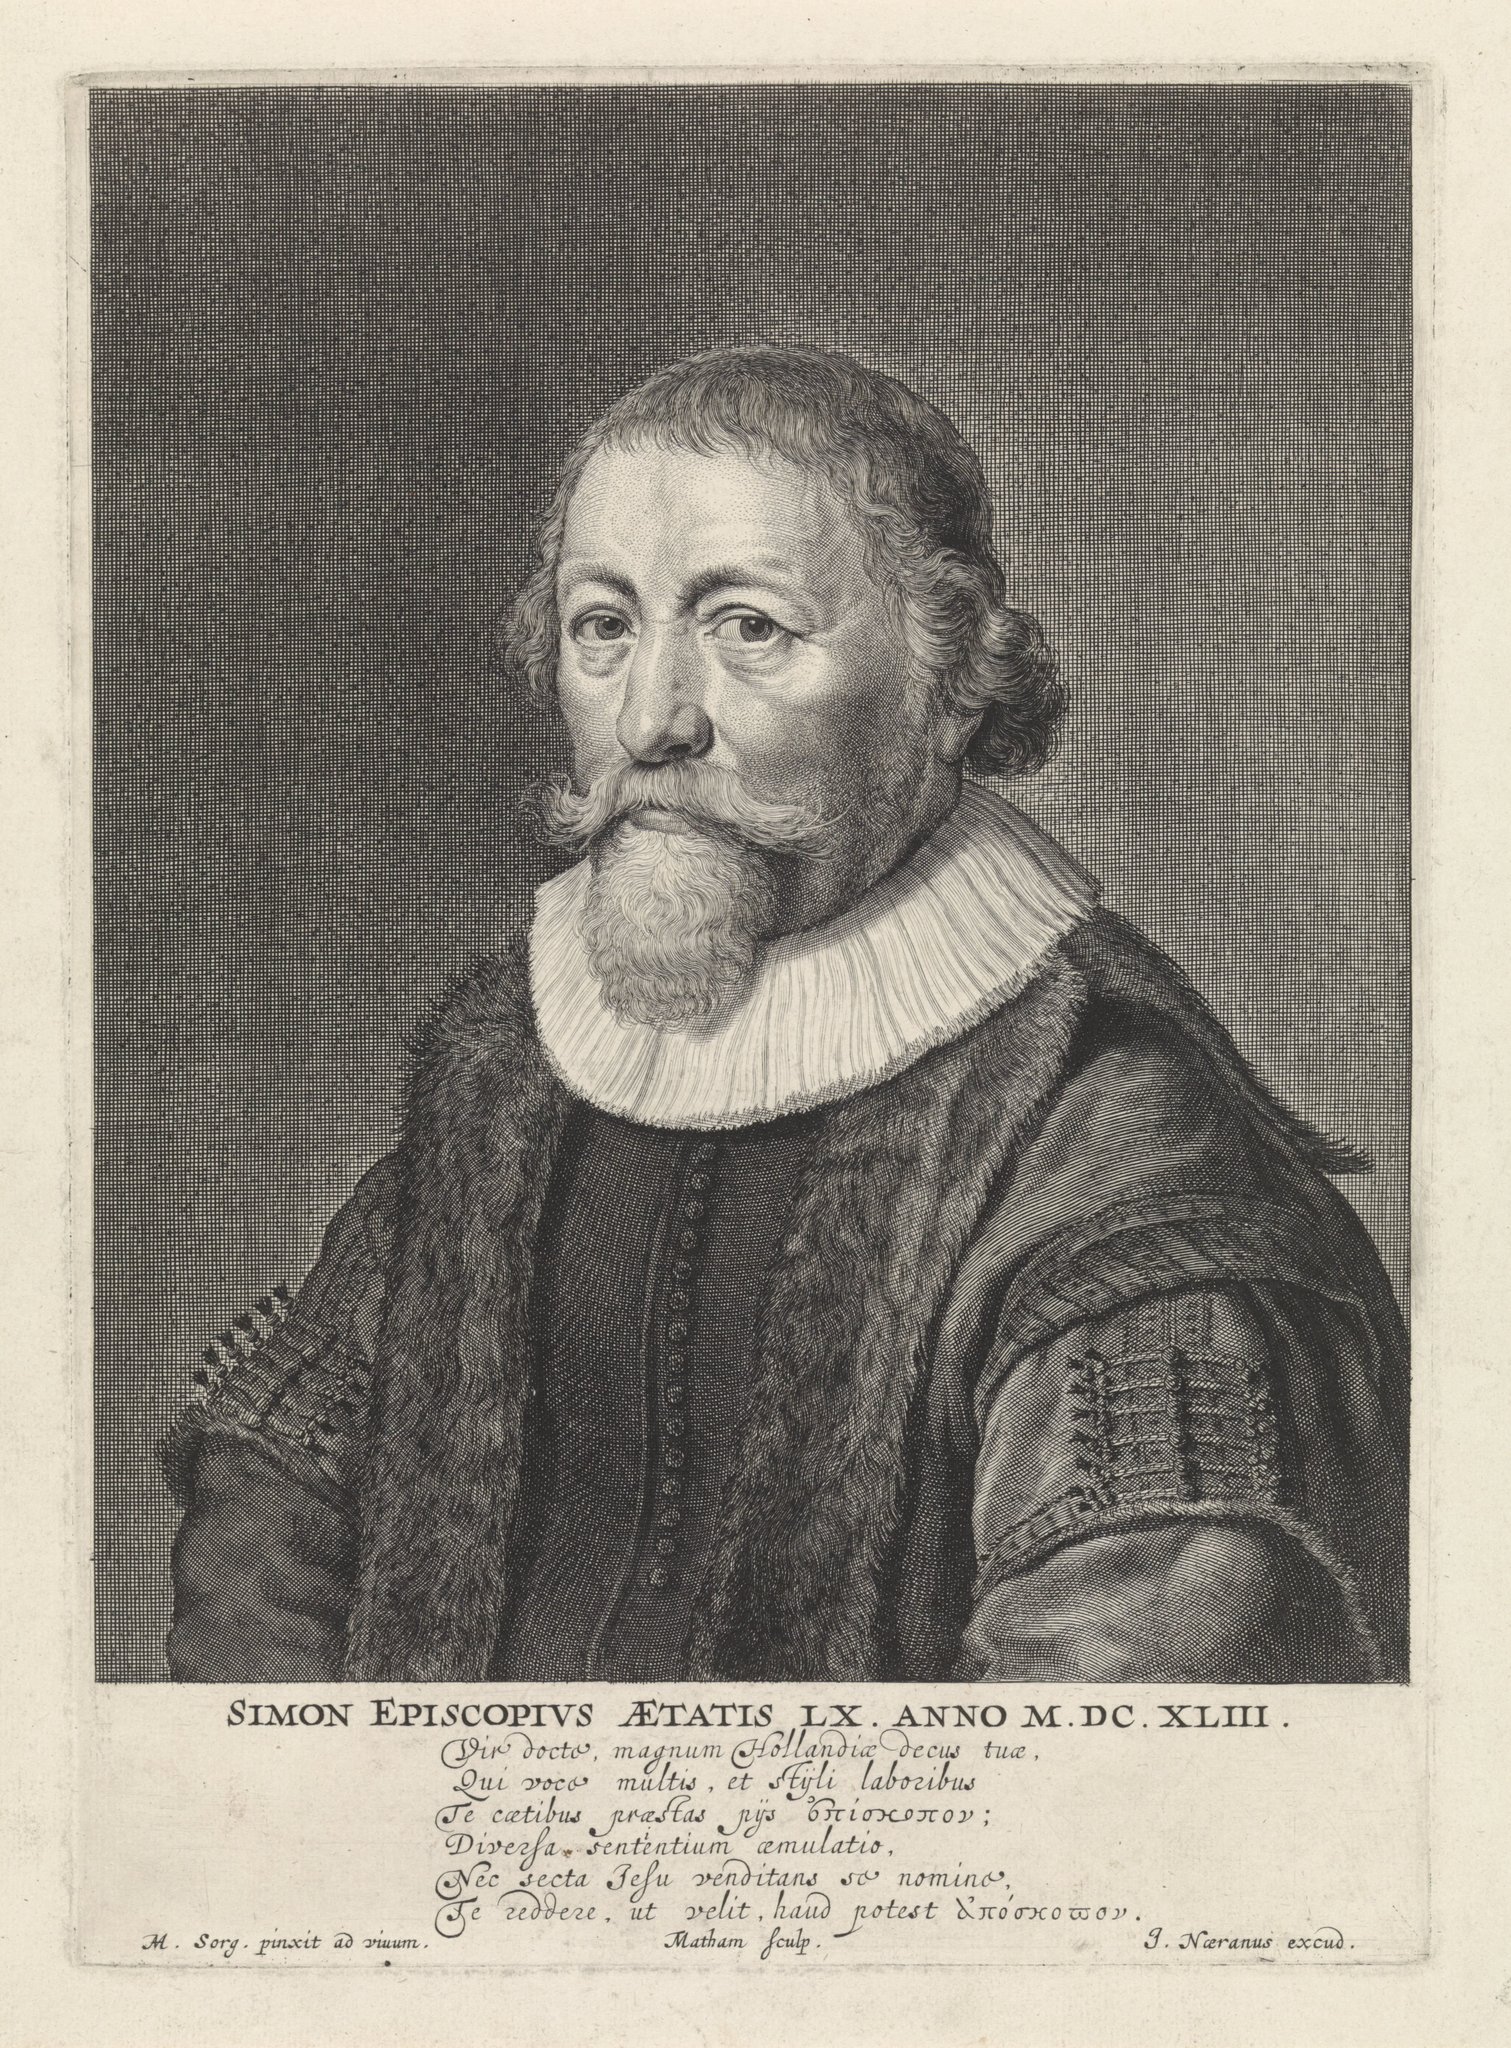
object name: print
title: Portret van Simon Bisschop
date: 1643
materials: paper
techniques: engraving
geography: rotterdam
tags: amsterdam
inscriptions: collector's mark: Lugt 240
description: Portret van Simon Bisschop, oftewel Simon Episcopius, protestantse theoloog in Leiden, op 60-jarige leeftijd.